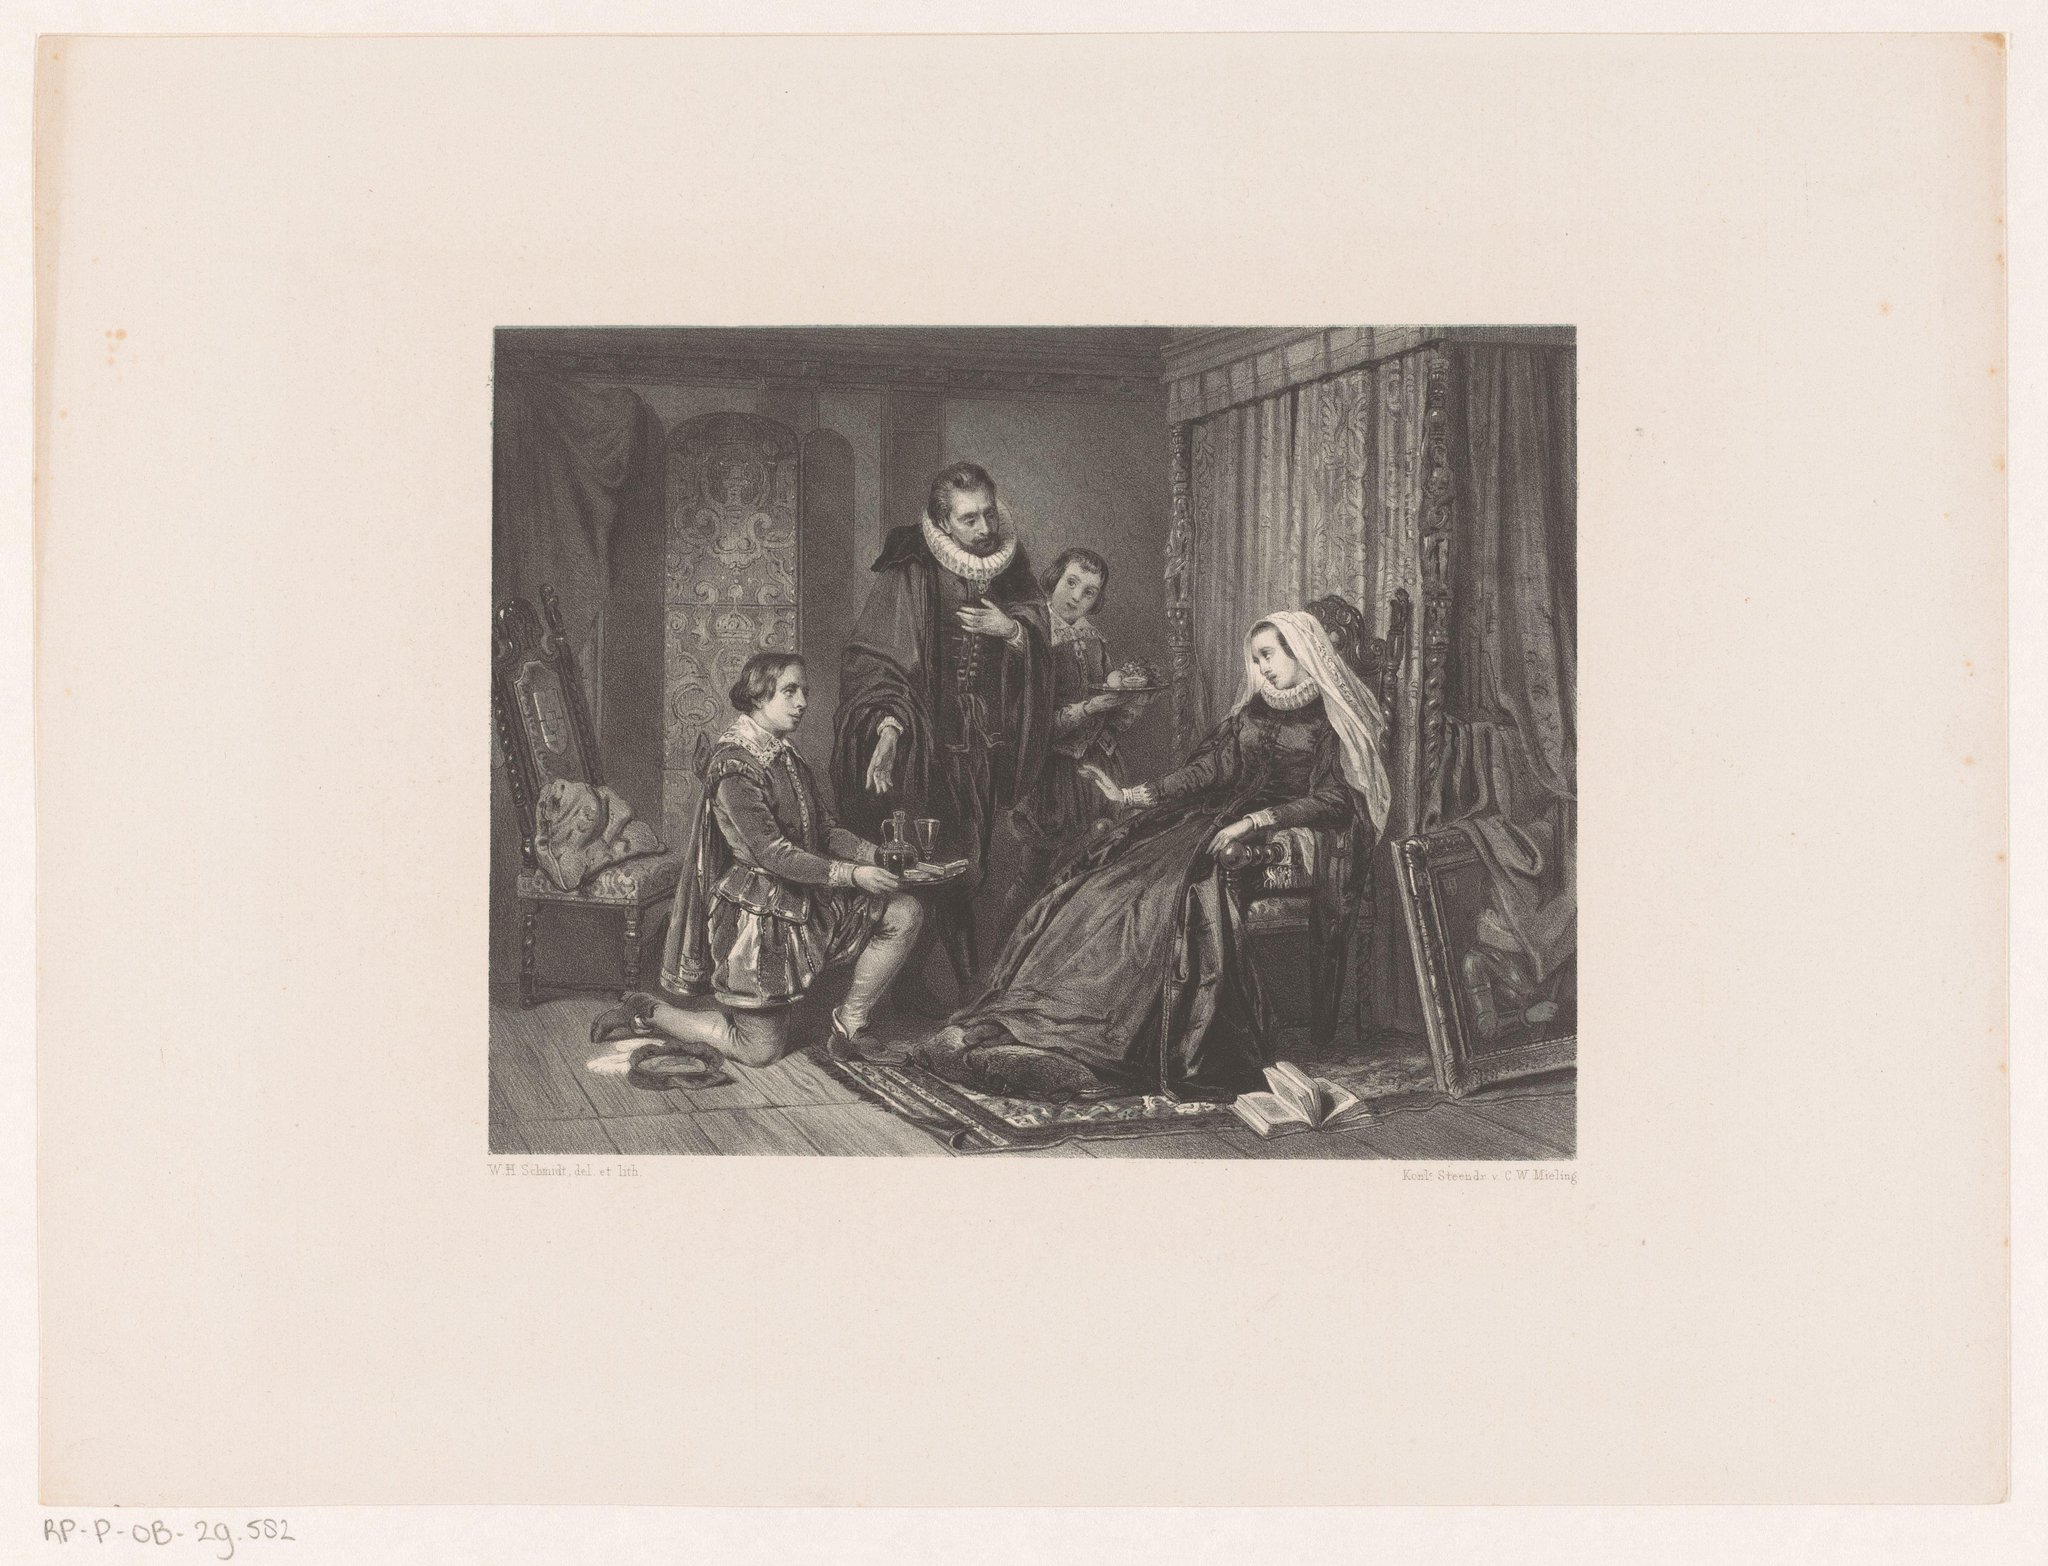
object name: print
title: Vrouw weigert aangeboden drank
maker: willem hendrik schmidt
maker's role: draughtsman, painter, print maker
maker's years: 1809-1849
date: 1847-1849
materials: paper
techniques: lithograph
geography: the hague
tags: gifts being refused, presents offered to the beloved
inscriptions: collector's mark: Lugt 2228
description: Een man en twee bedienden bieden een zittende vrouw drank en fruit aan. De vrouw maakt met haar hand een weigerend gebaar.